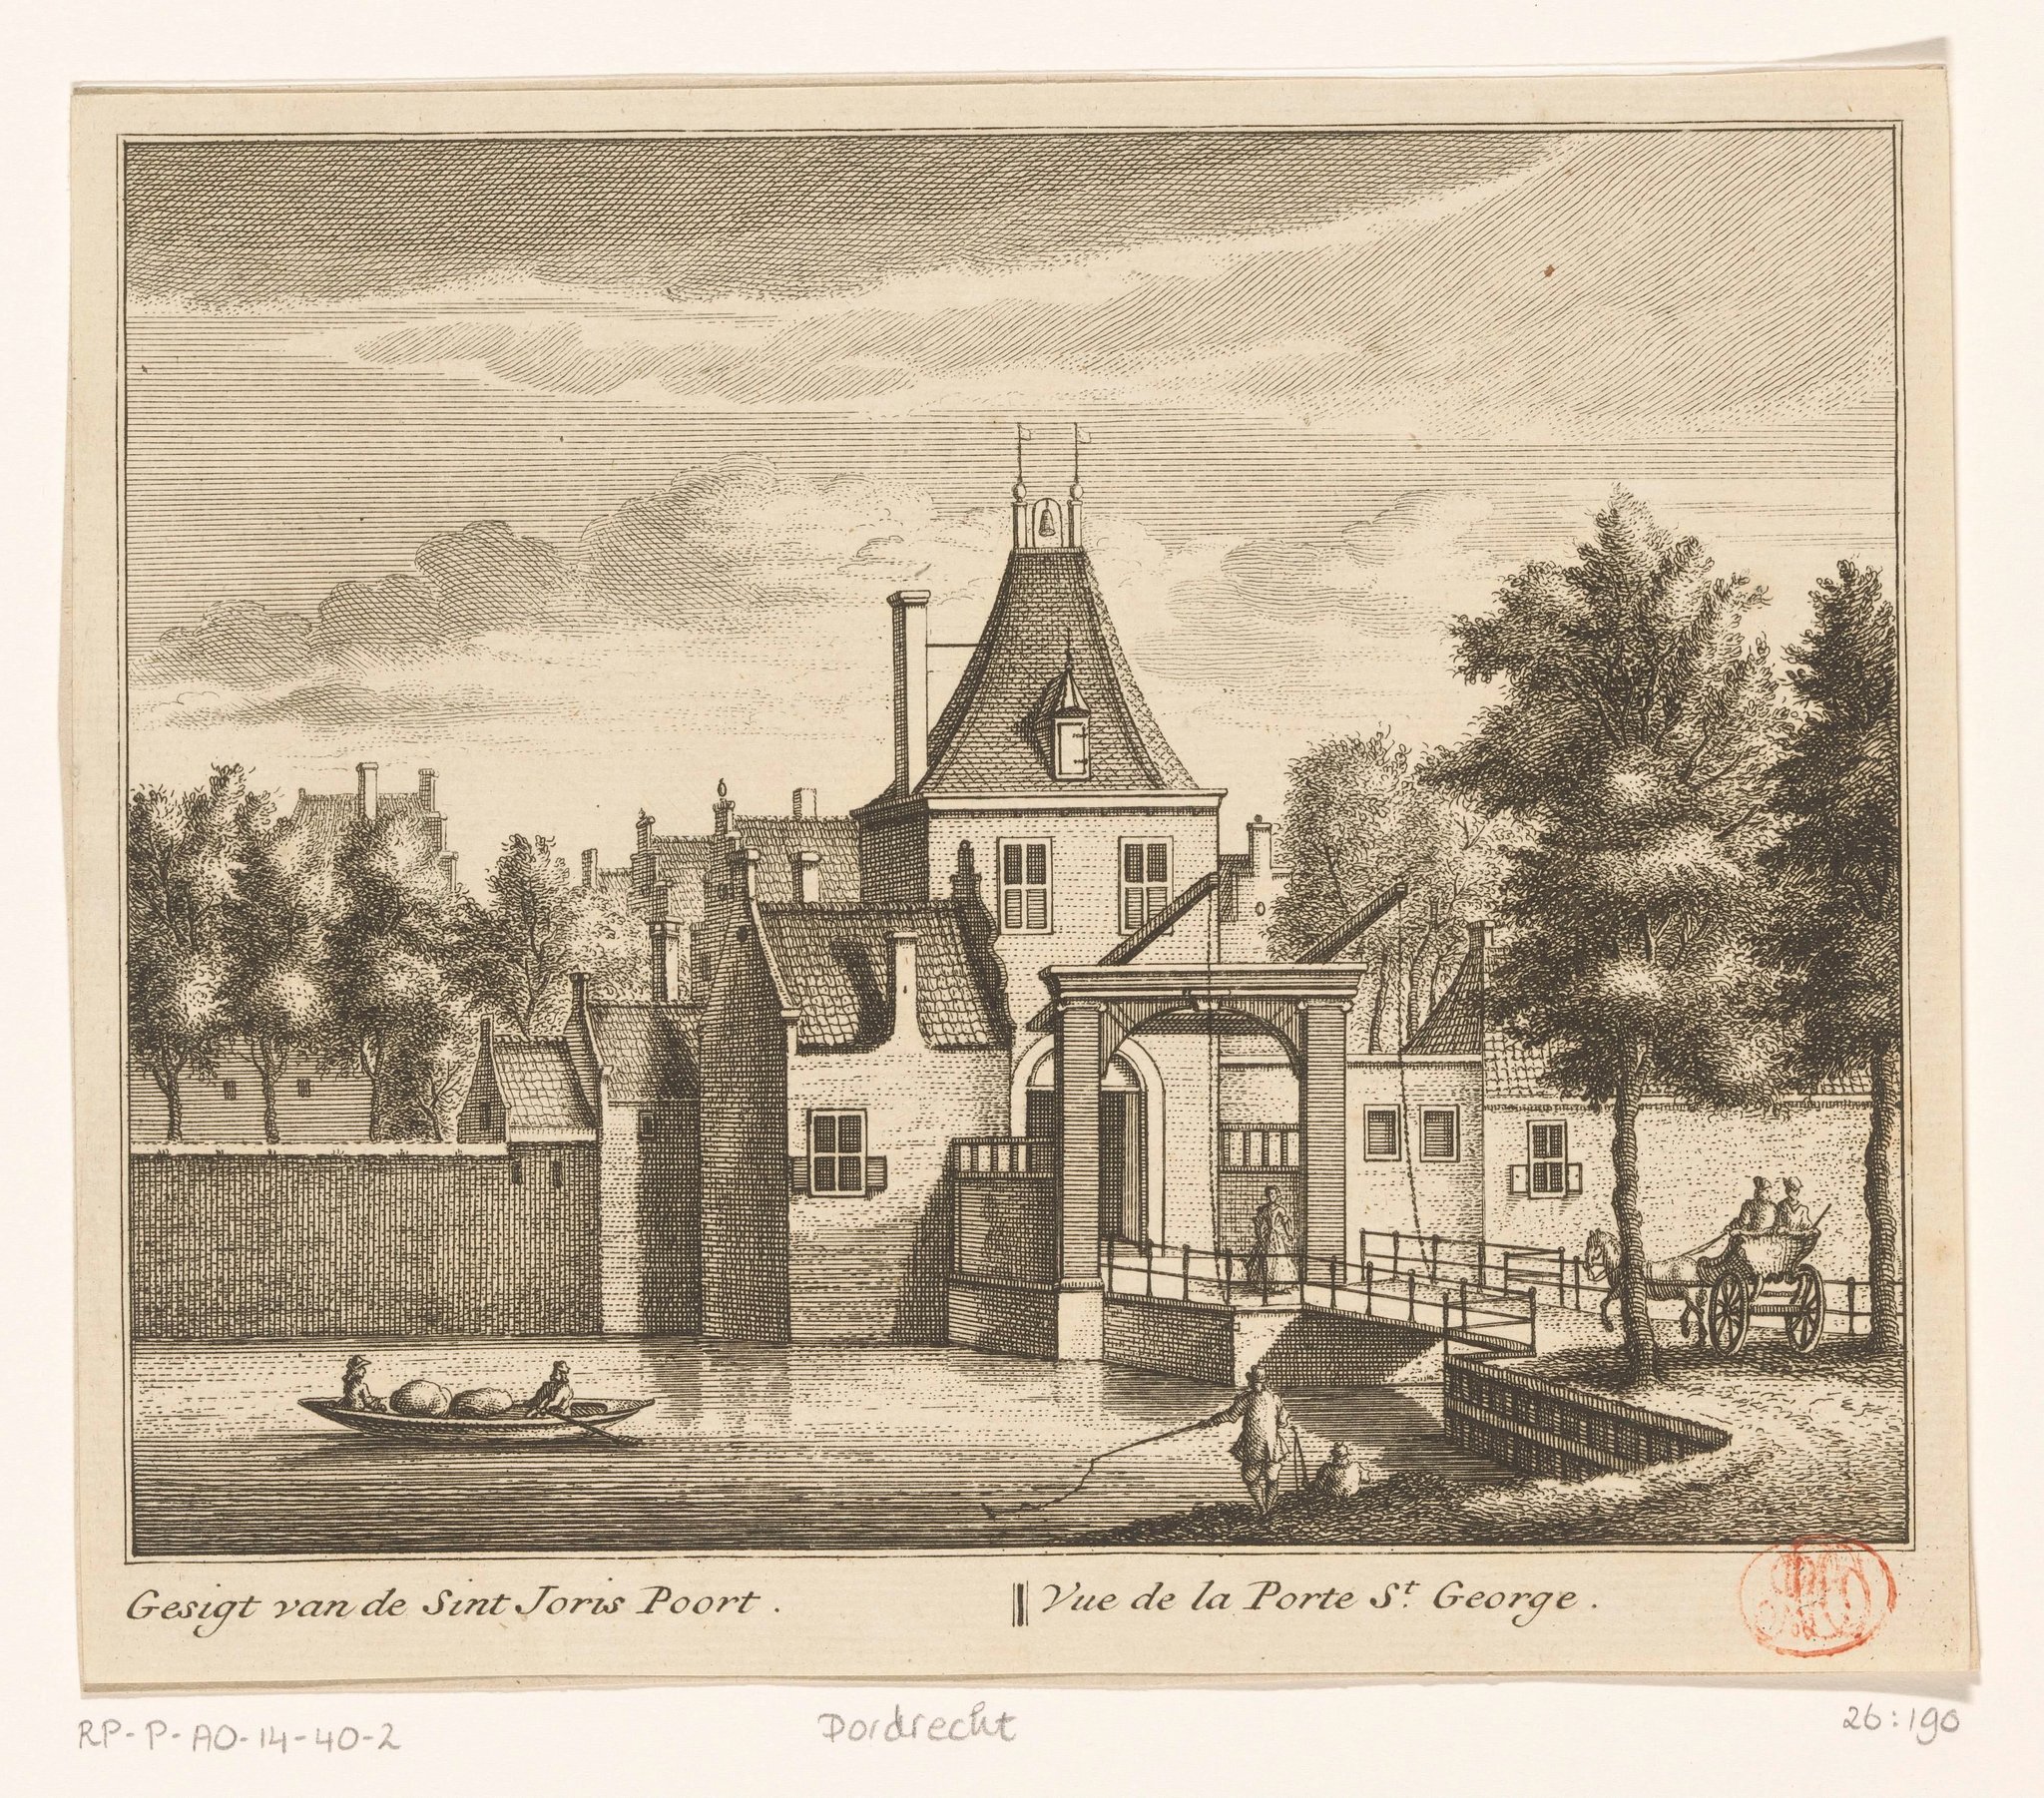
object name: print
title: Gezicht op de Sint-Jorispoort te Dordrecht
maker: leonard schenk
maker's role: print maker, publisher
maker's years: 1696-1767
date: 1736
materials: paper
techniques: etching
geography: amsterdam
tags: bridge in city across river, canal, etc. (+ city(-scape) with figures, staffage), city-gate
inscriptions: collector's mark: Lugt 195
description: Prent ook gebruikt in: Rademaker, Abraham. Alle de voornaamste gesigten van de wydberoemde steeden Alkmaar, Delft en Dordregt (...) / Toutes les principales vuës de la fameuse villes d'Alcmar, Delft & Dordregt (…). Amsterdam: Leonard Schenk, 1736. Zie ook RP-P-AO-14-38, RP-P-AO-14-40-1, RP-P-AO-14-41-1 en RP-P-AO-14-41-2.